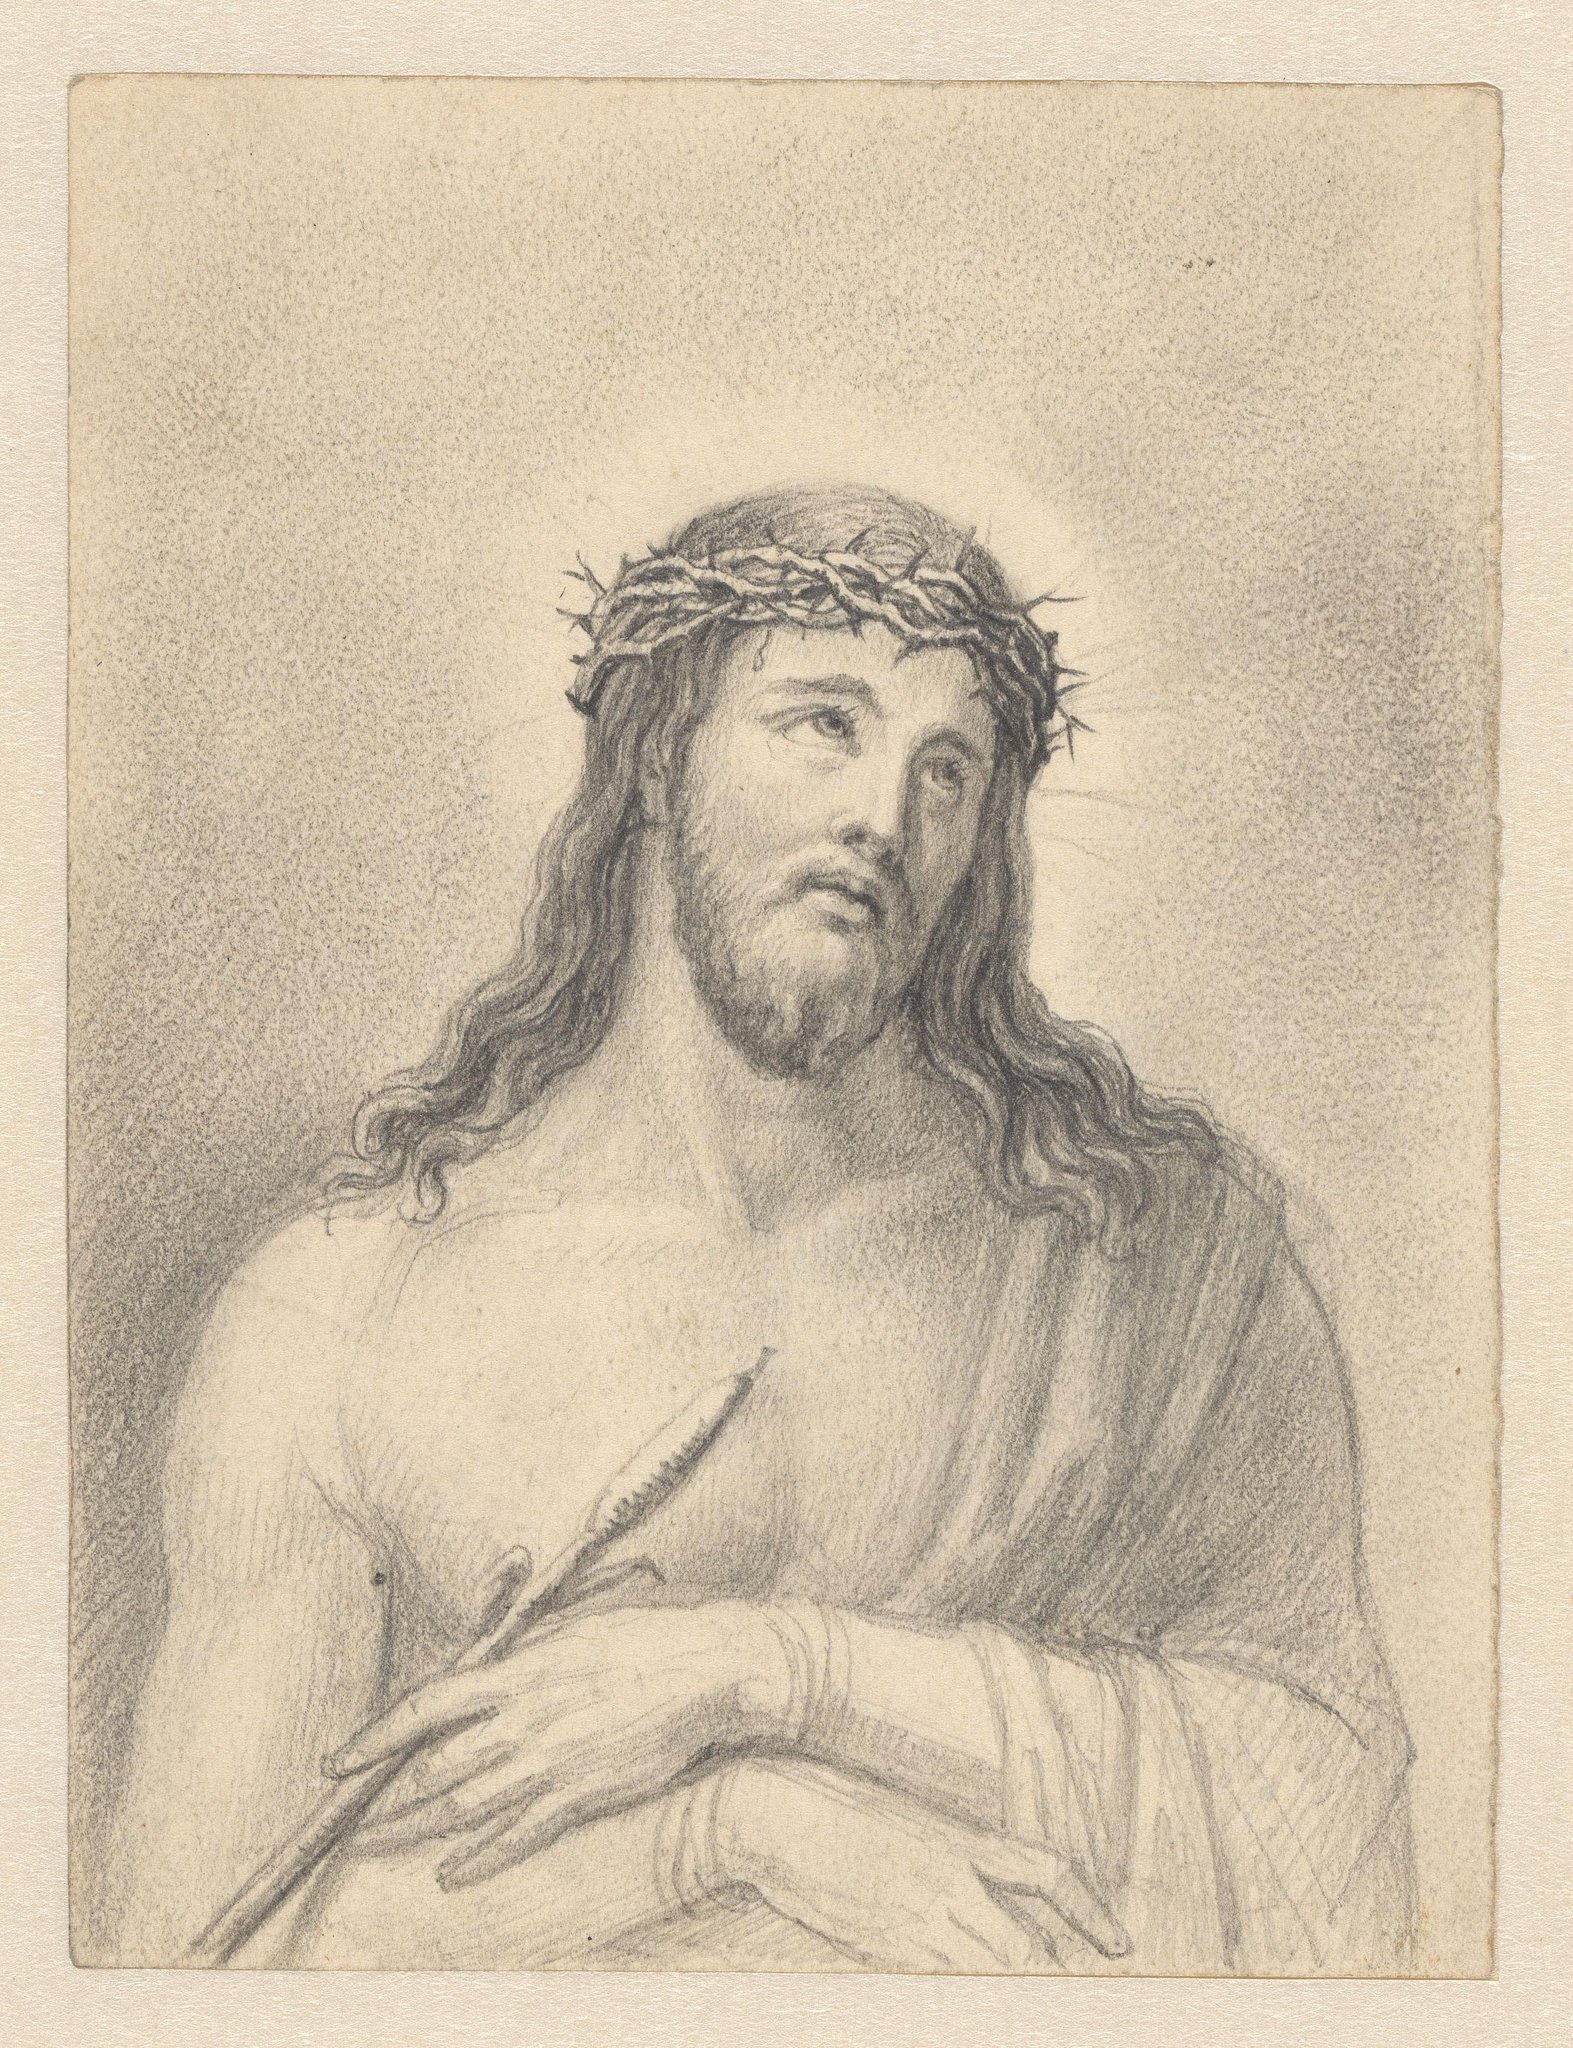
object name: drawing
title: Christus met doornenkroon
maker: joannes carolus alberdingk thijm (jan)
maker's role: pater, schrijver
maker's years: 1847-1926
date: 1857-1870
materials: paper, pencil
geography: netherlands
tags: head of christ with crown of thorns